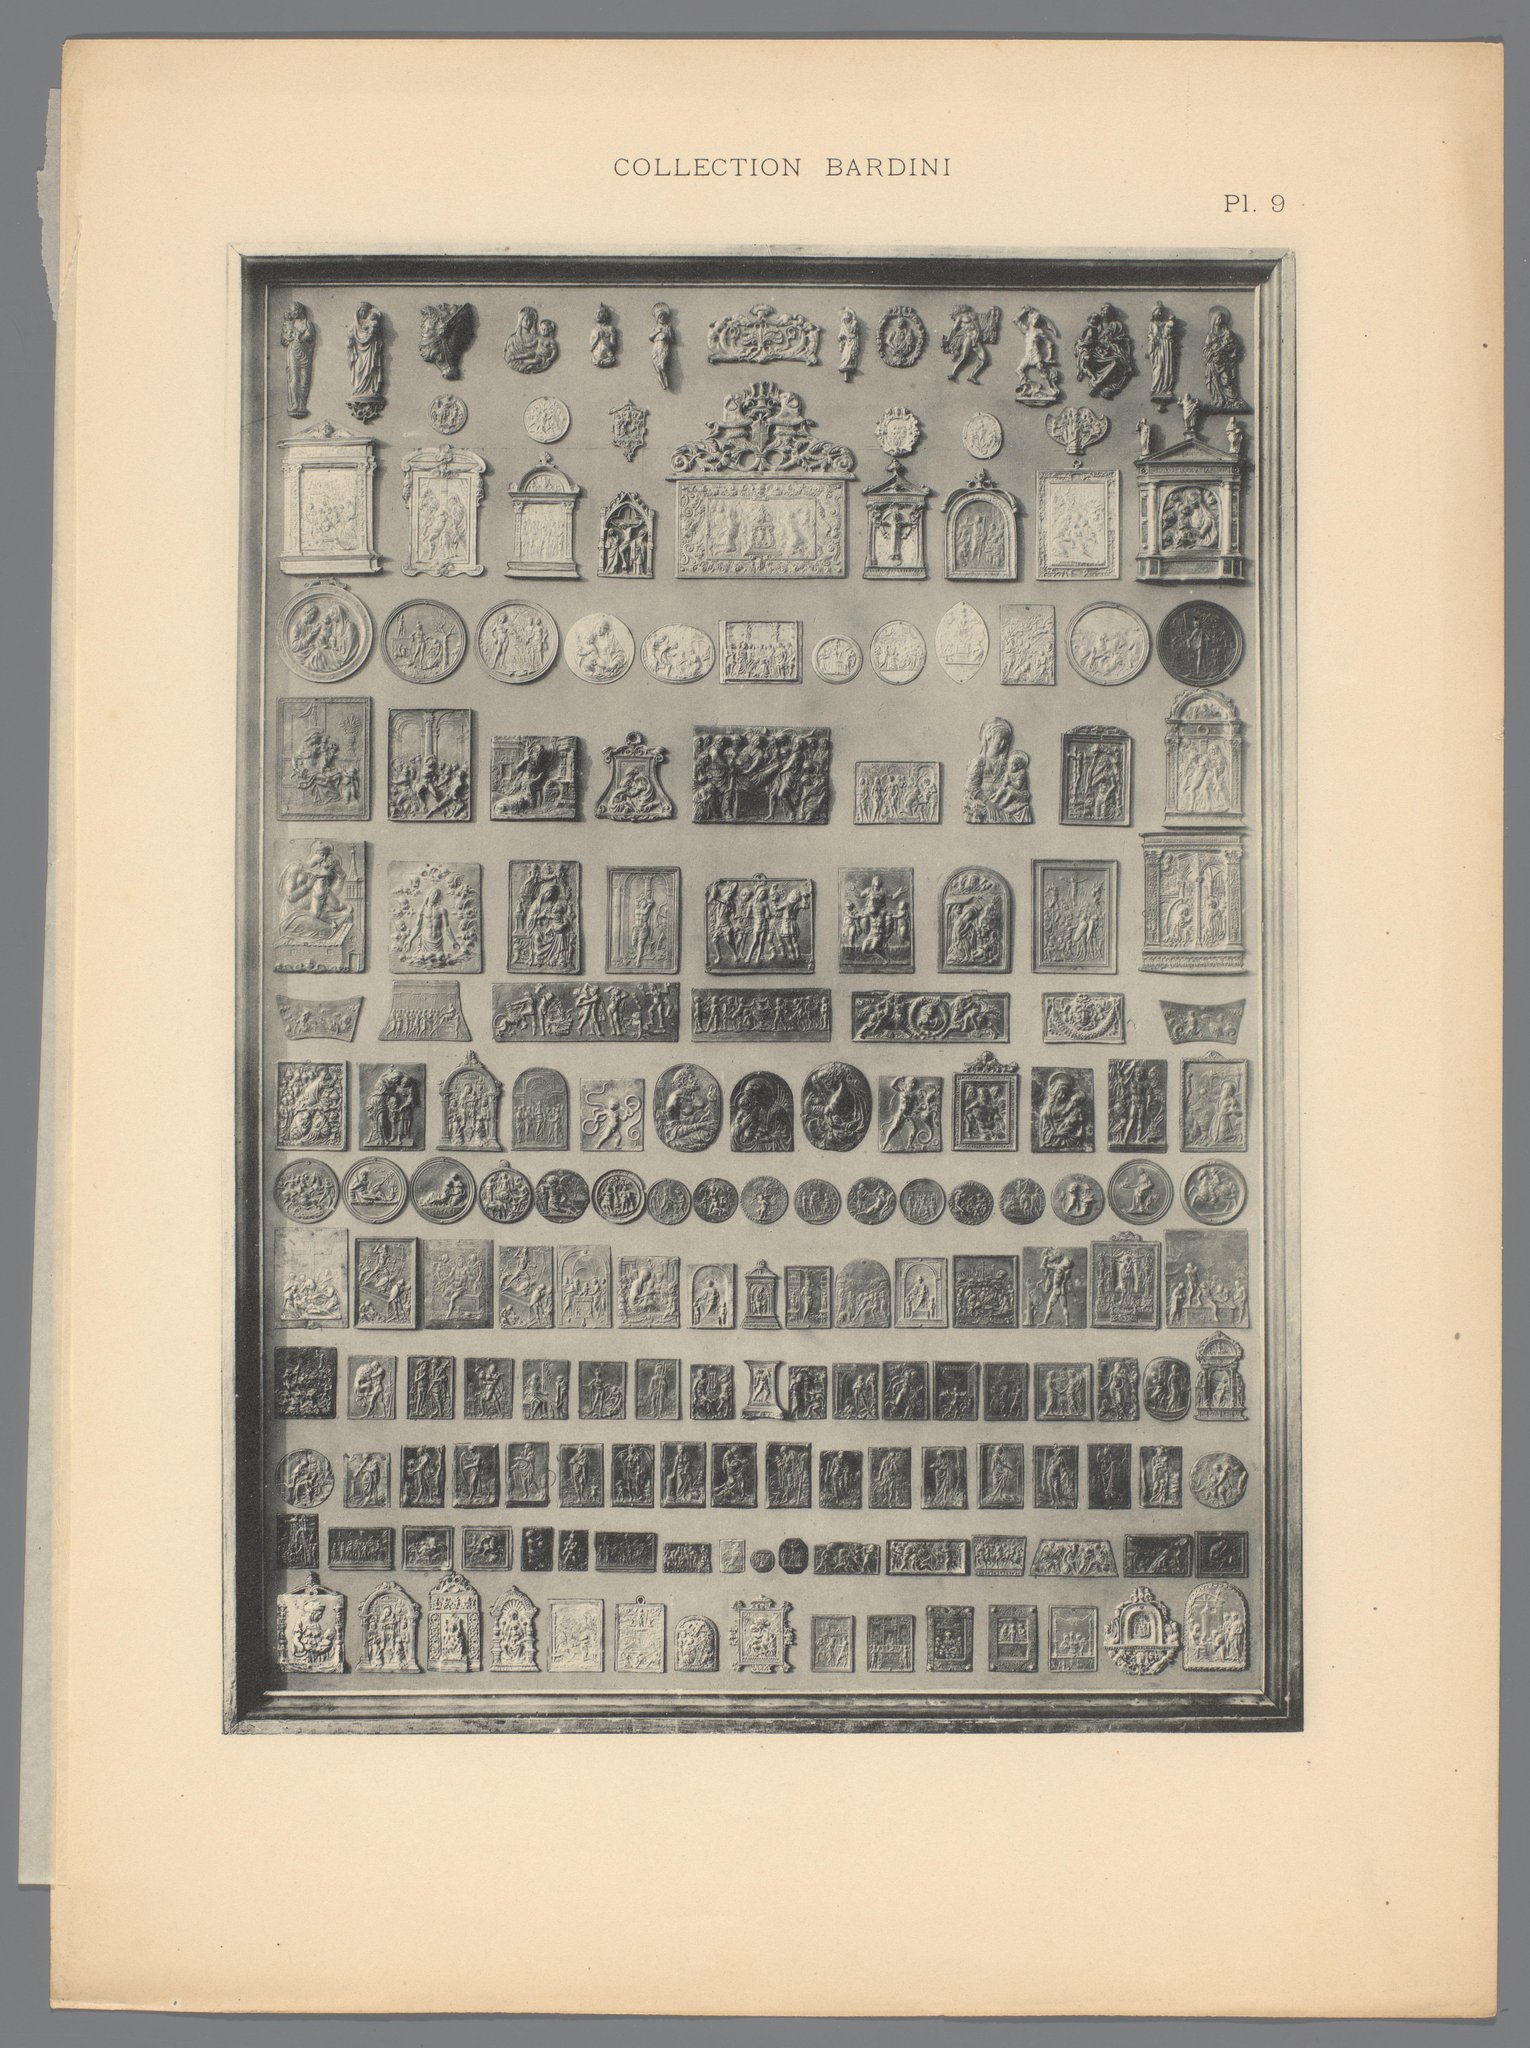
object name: photomechanical print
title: Verzameling gedecoreerde metalen plaatjes opgezet in een lijst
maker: Anonymous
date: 1875-1930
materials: paper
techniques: photograph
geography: florence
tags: minerals and metals, frame of painting, etc.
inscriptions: number: ‘Pl. 9’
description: Aan de prent is een dun vloeipapier bevestigd met daarop rode nummers gedrukt. Deze nummers vallen precies op de metalen plaatjes op de prent wanneer dit vel over de prent ligt.